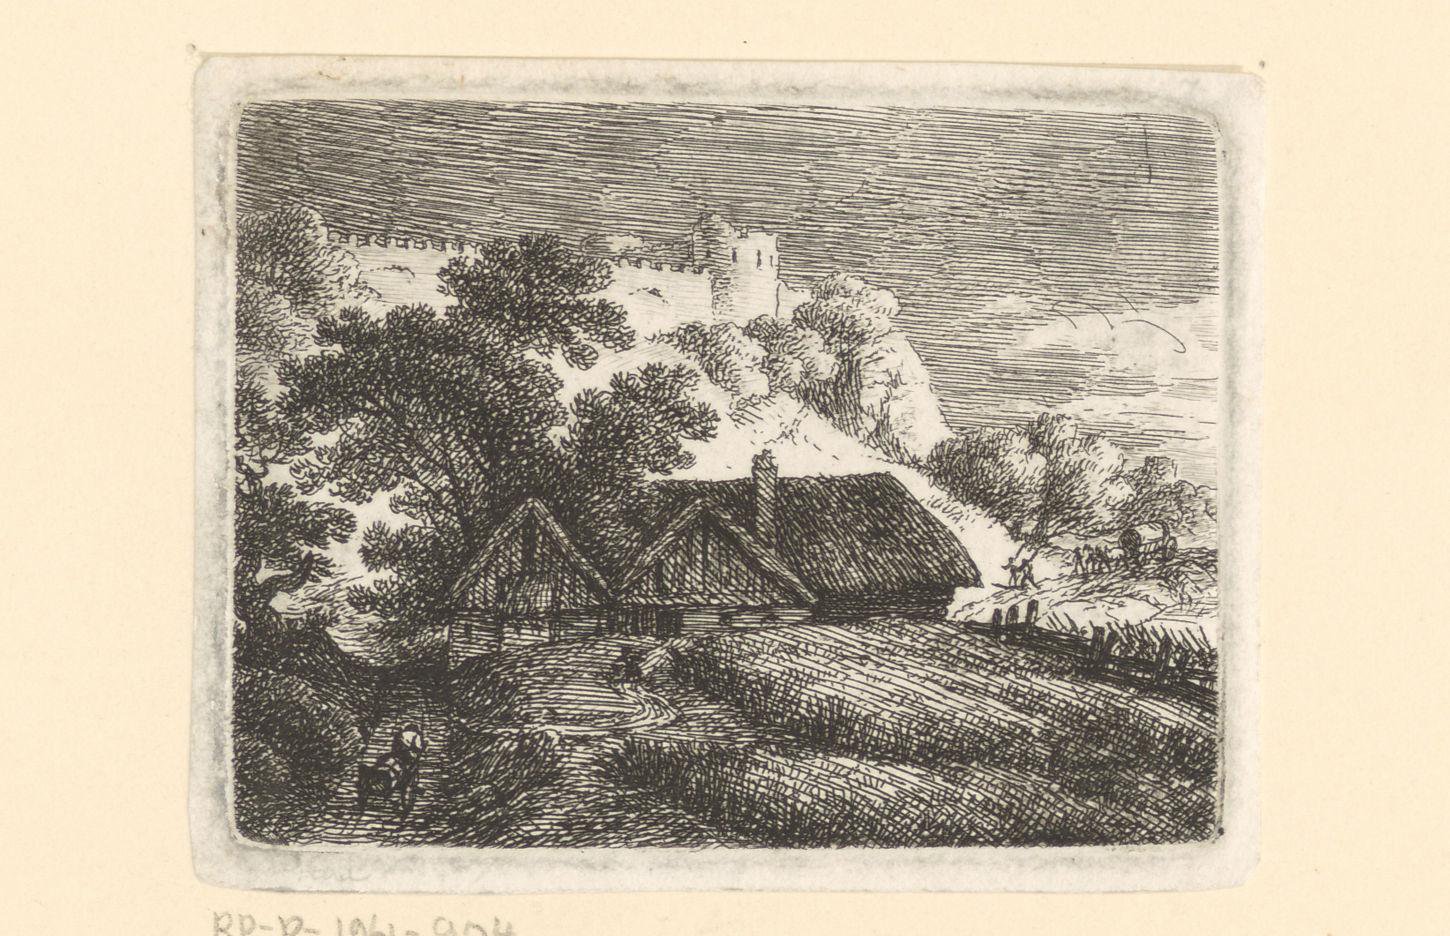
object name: print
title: Ruïnelandschap met landhuis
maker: ferdinand kobell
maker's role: artist, painter, print maker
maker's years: 1740-1799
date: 1750-1799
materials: paper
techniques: etching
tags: rural housing, e.g. country-house, villa, cottage, landscape with ruins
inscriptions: collector's mark: Lugt 2228